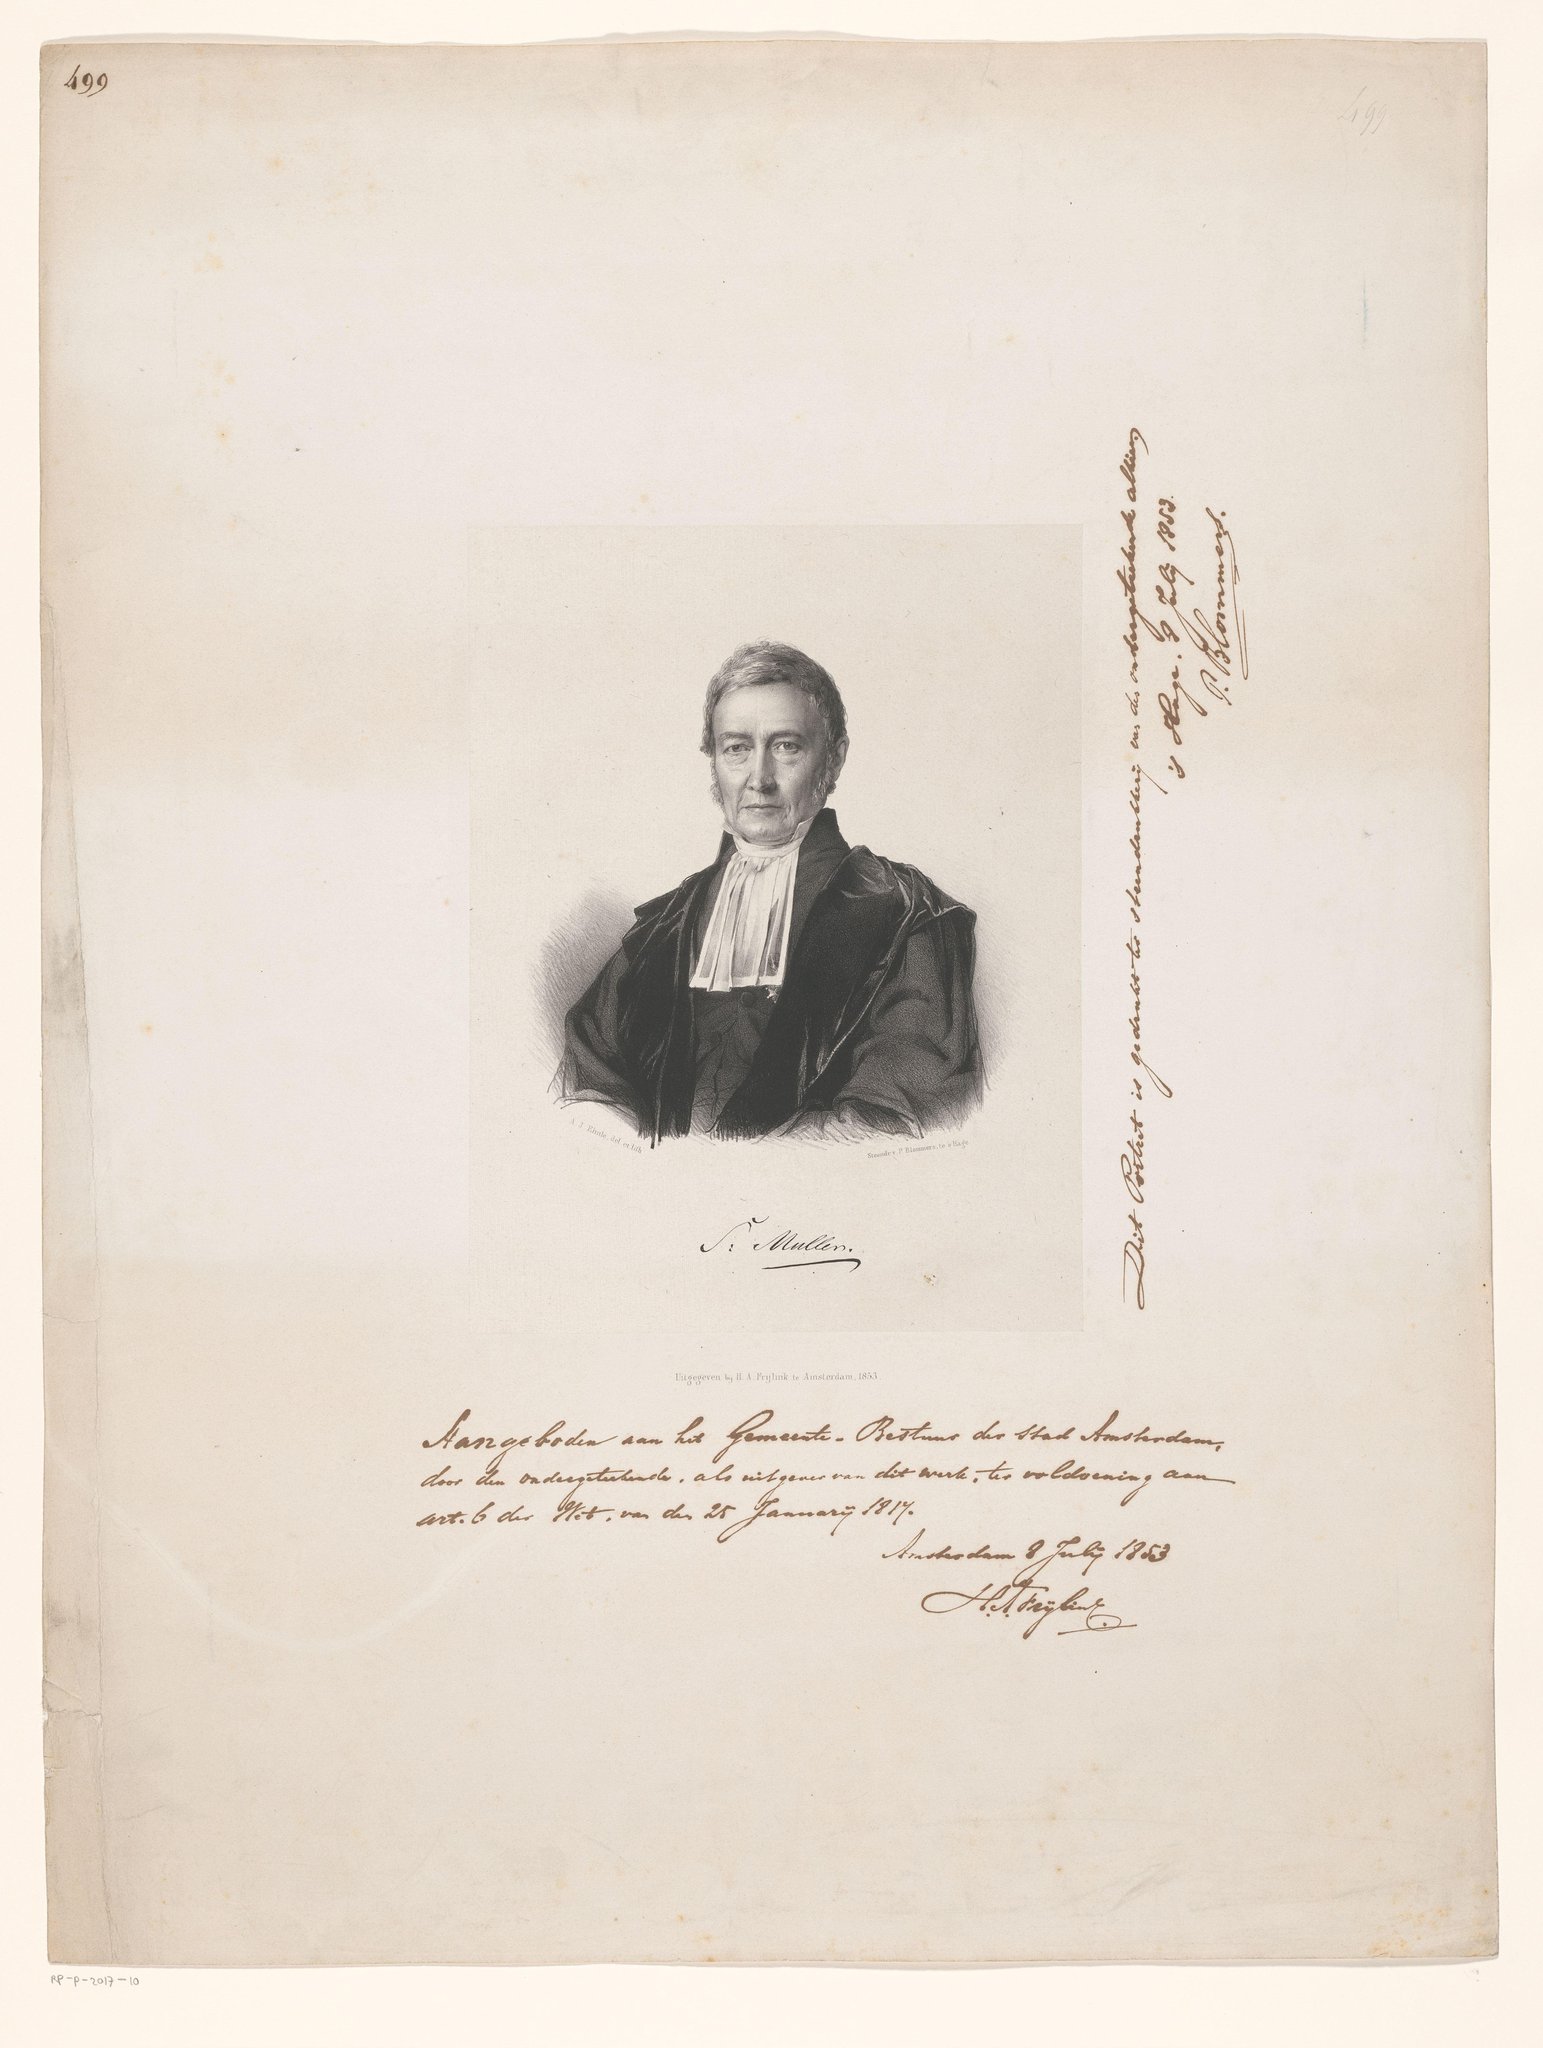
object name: print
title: Portret van Samuel Muller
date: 1853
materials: paper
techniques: lithograph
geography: amsterdam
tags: amsterdam, samuel muller (1785-1875), knighthood order, historical persons (+ (full) bust portrait)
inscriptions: : ‘Aangeboden aan het Gemeente-Bestuur der stad Amsterdam, / door den ondergeteekende, als uitgever van dit werk, ter voldoening aan art. 6 der wet van den 25 Januarij 1817. / Amsterdam 8 julij 1853 / H. A. Frijlink’, : ‘Dit portret is gedrukt te steendrukkerij van der ondergeteekende alhier / 's Hage 8 julij 1853 / P. Blommers’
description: De geportretteerde draagt een toga met bef en ridderode.